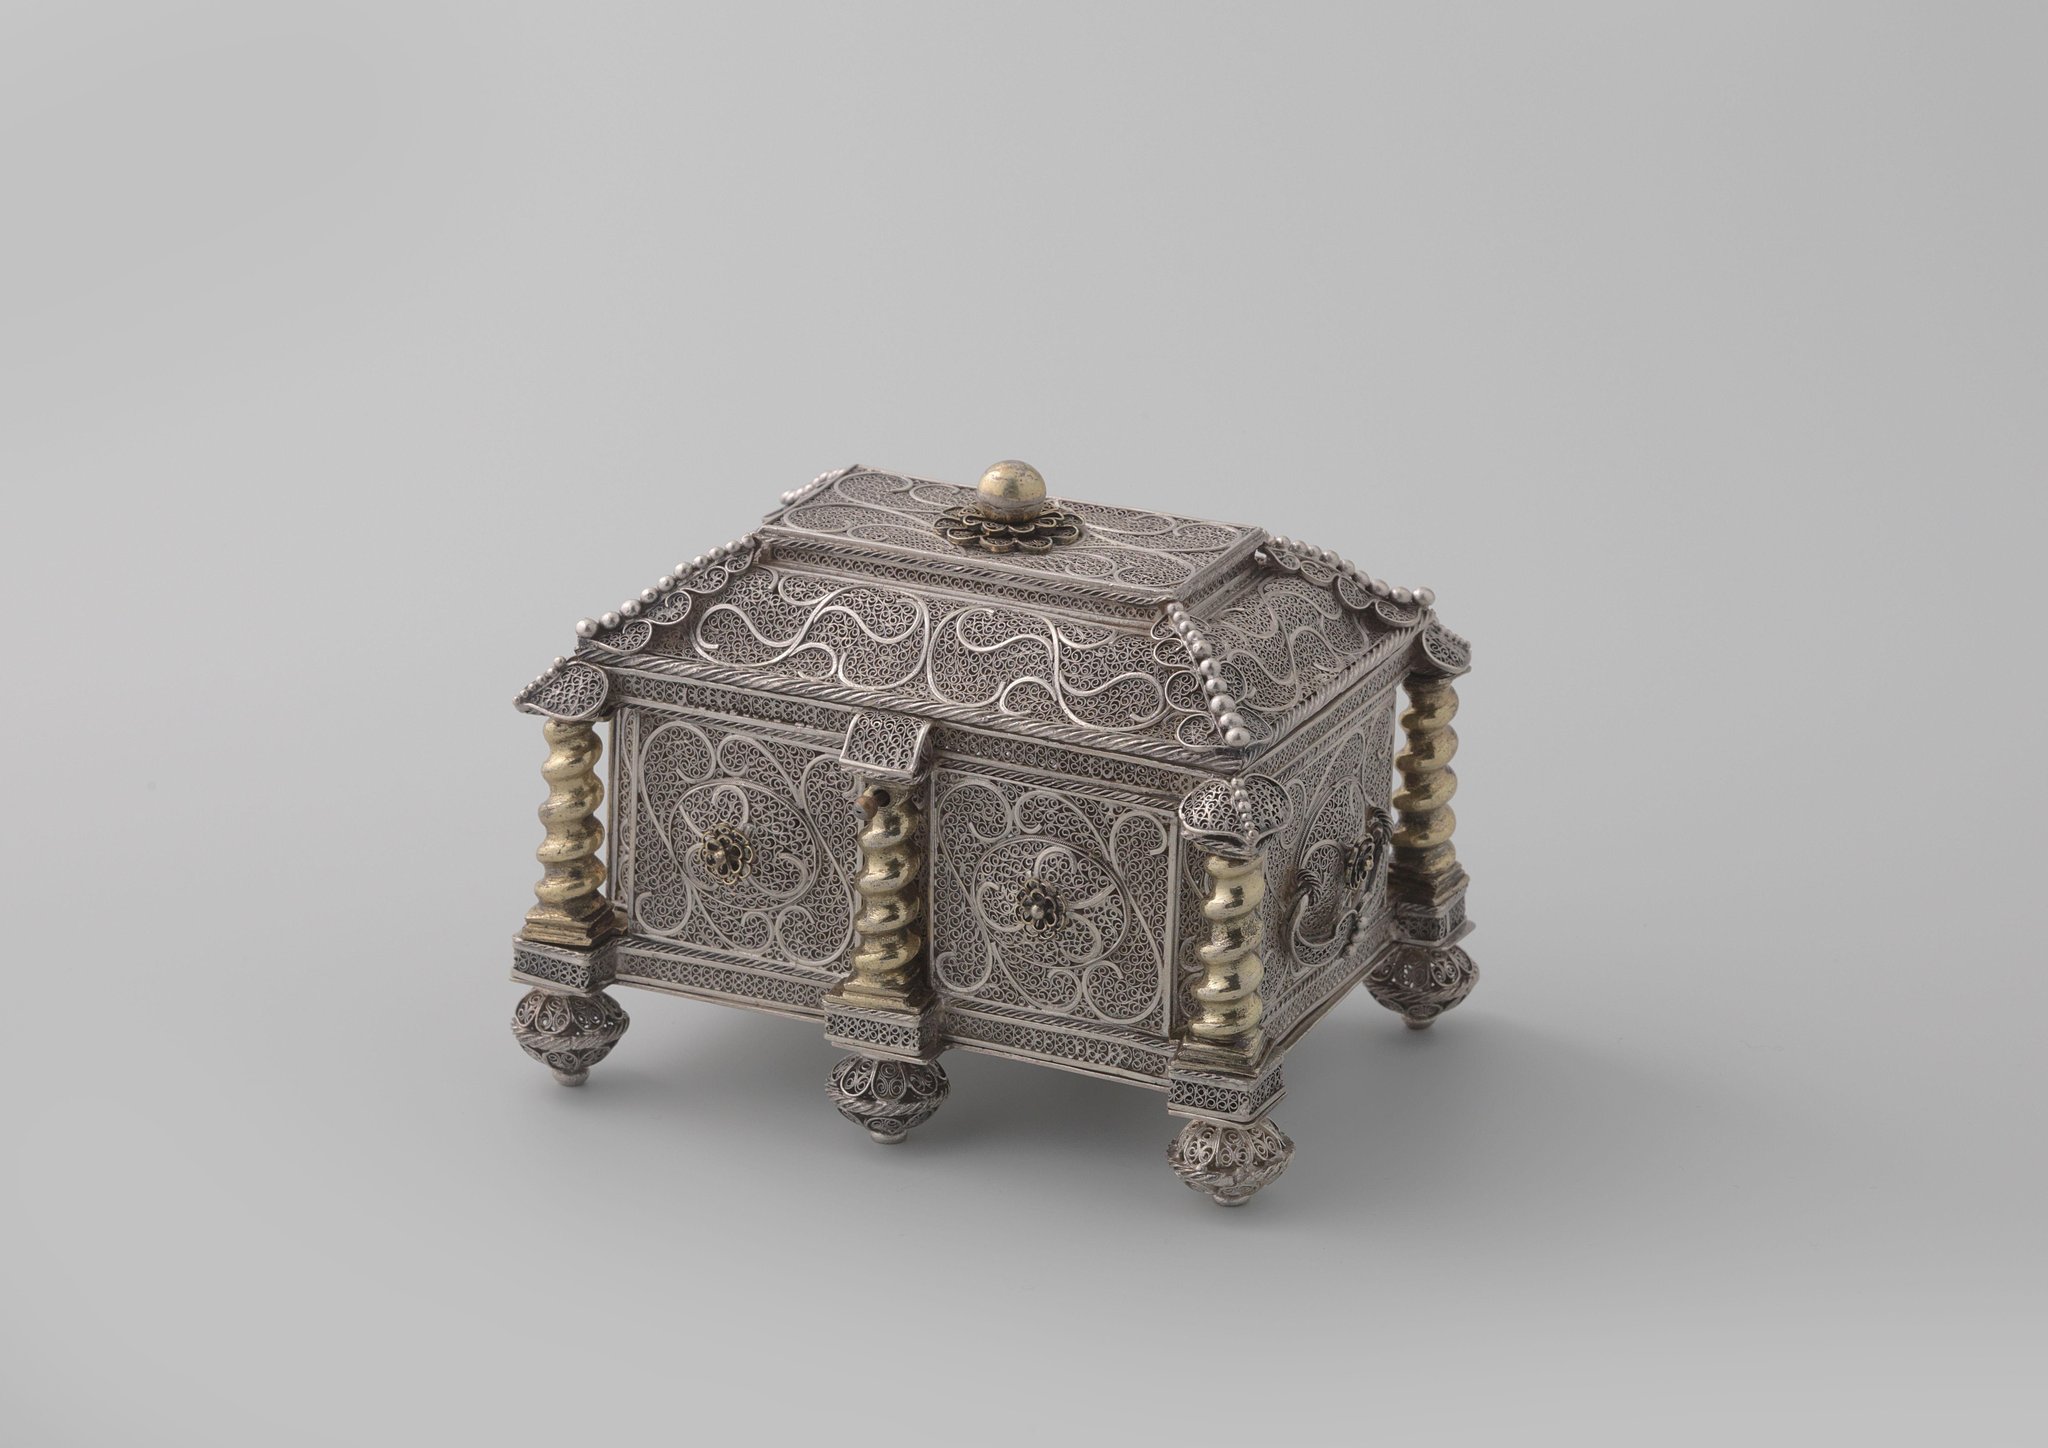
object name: knottekist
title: Knottekist van zilver met asymmetrische figuren in filigrein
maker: Anonymous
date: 1650-1700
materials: silver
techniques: filigree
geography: netherlands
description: Koffer van zilver filigrein. Het filigrein is opgebouwd uit asymmetrische figuren. Aan beide zijden losse hengsels.